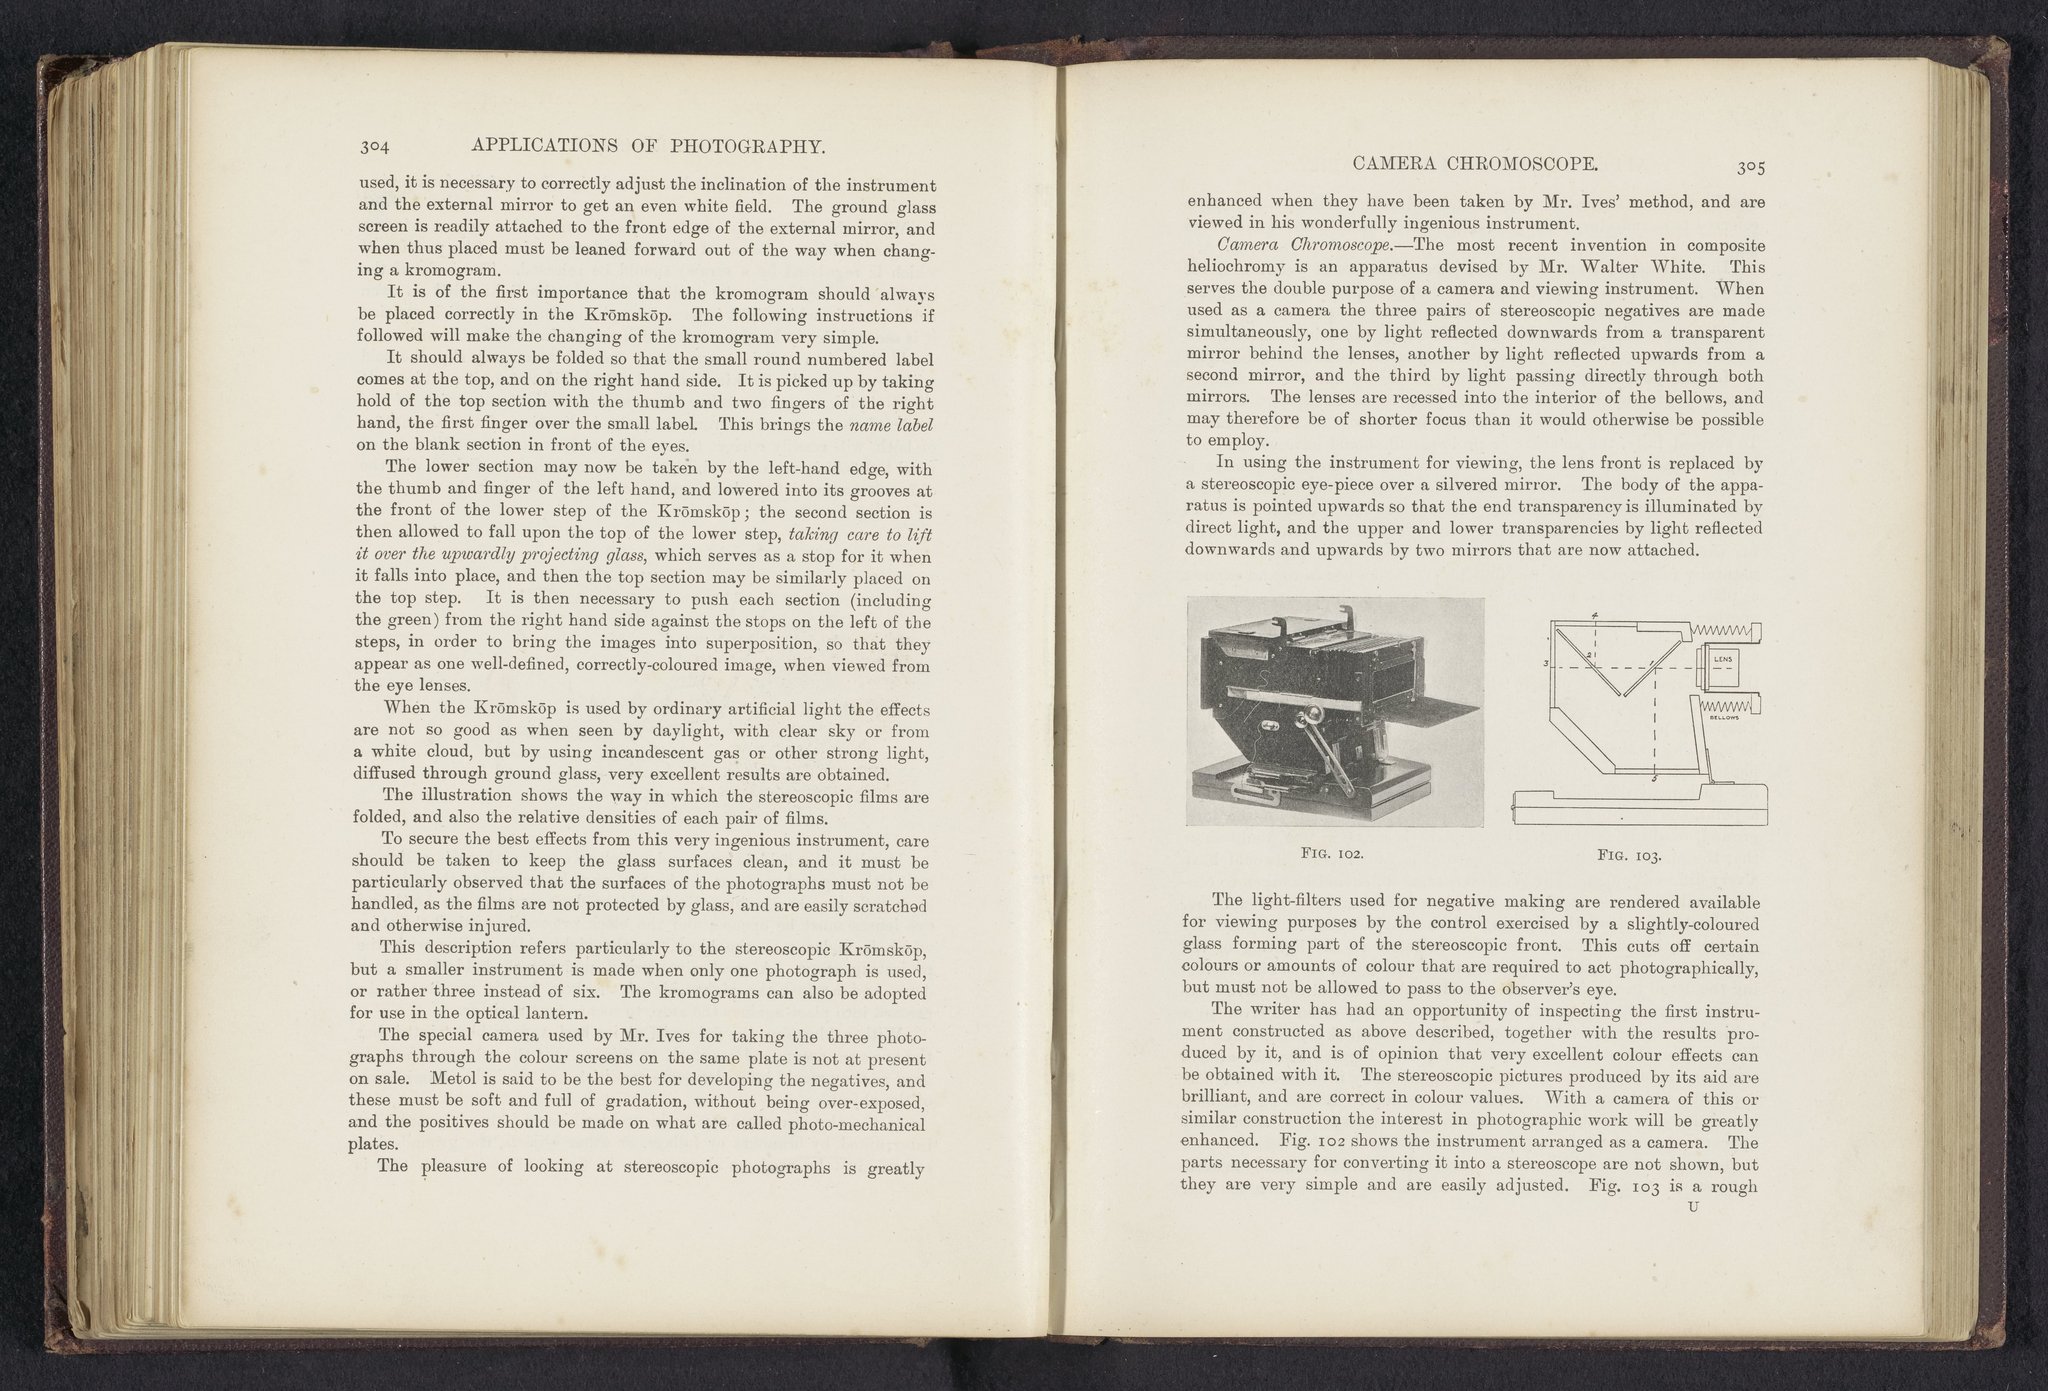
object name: page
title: Chromoscope-camera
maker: Anonymous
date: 1889-1899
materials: paper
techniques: autotype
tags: camera ~ photography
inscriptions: number: ‘Fig. 102.’